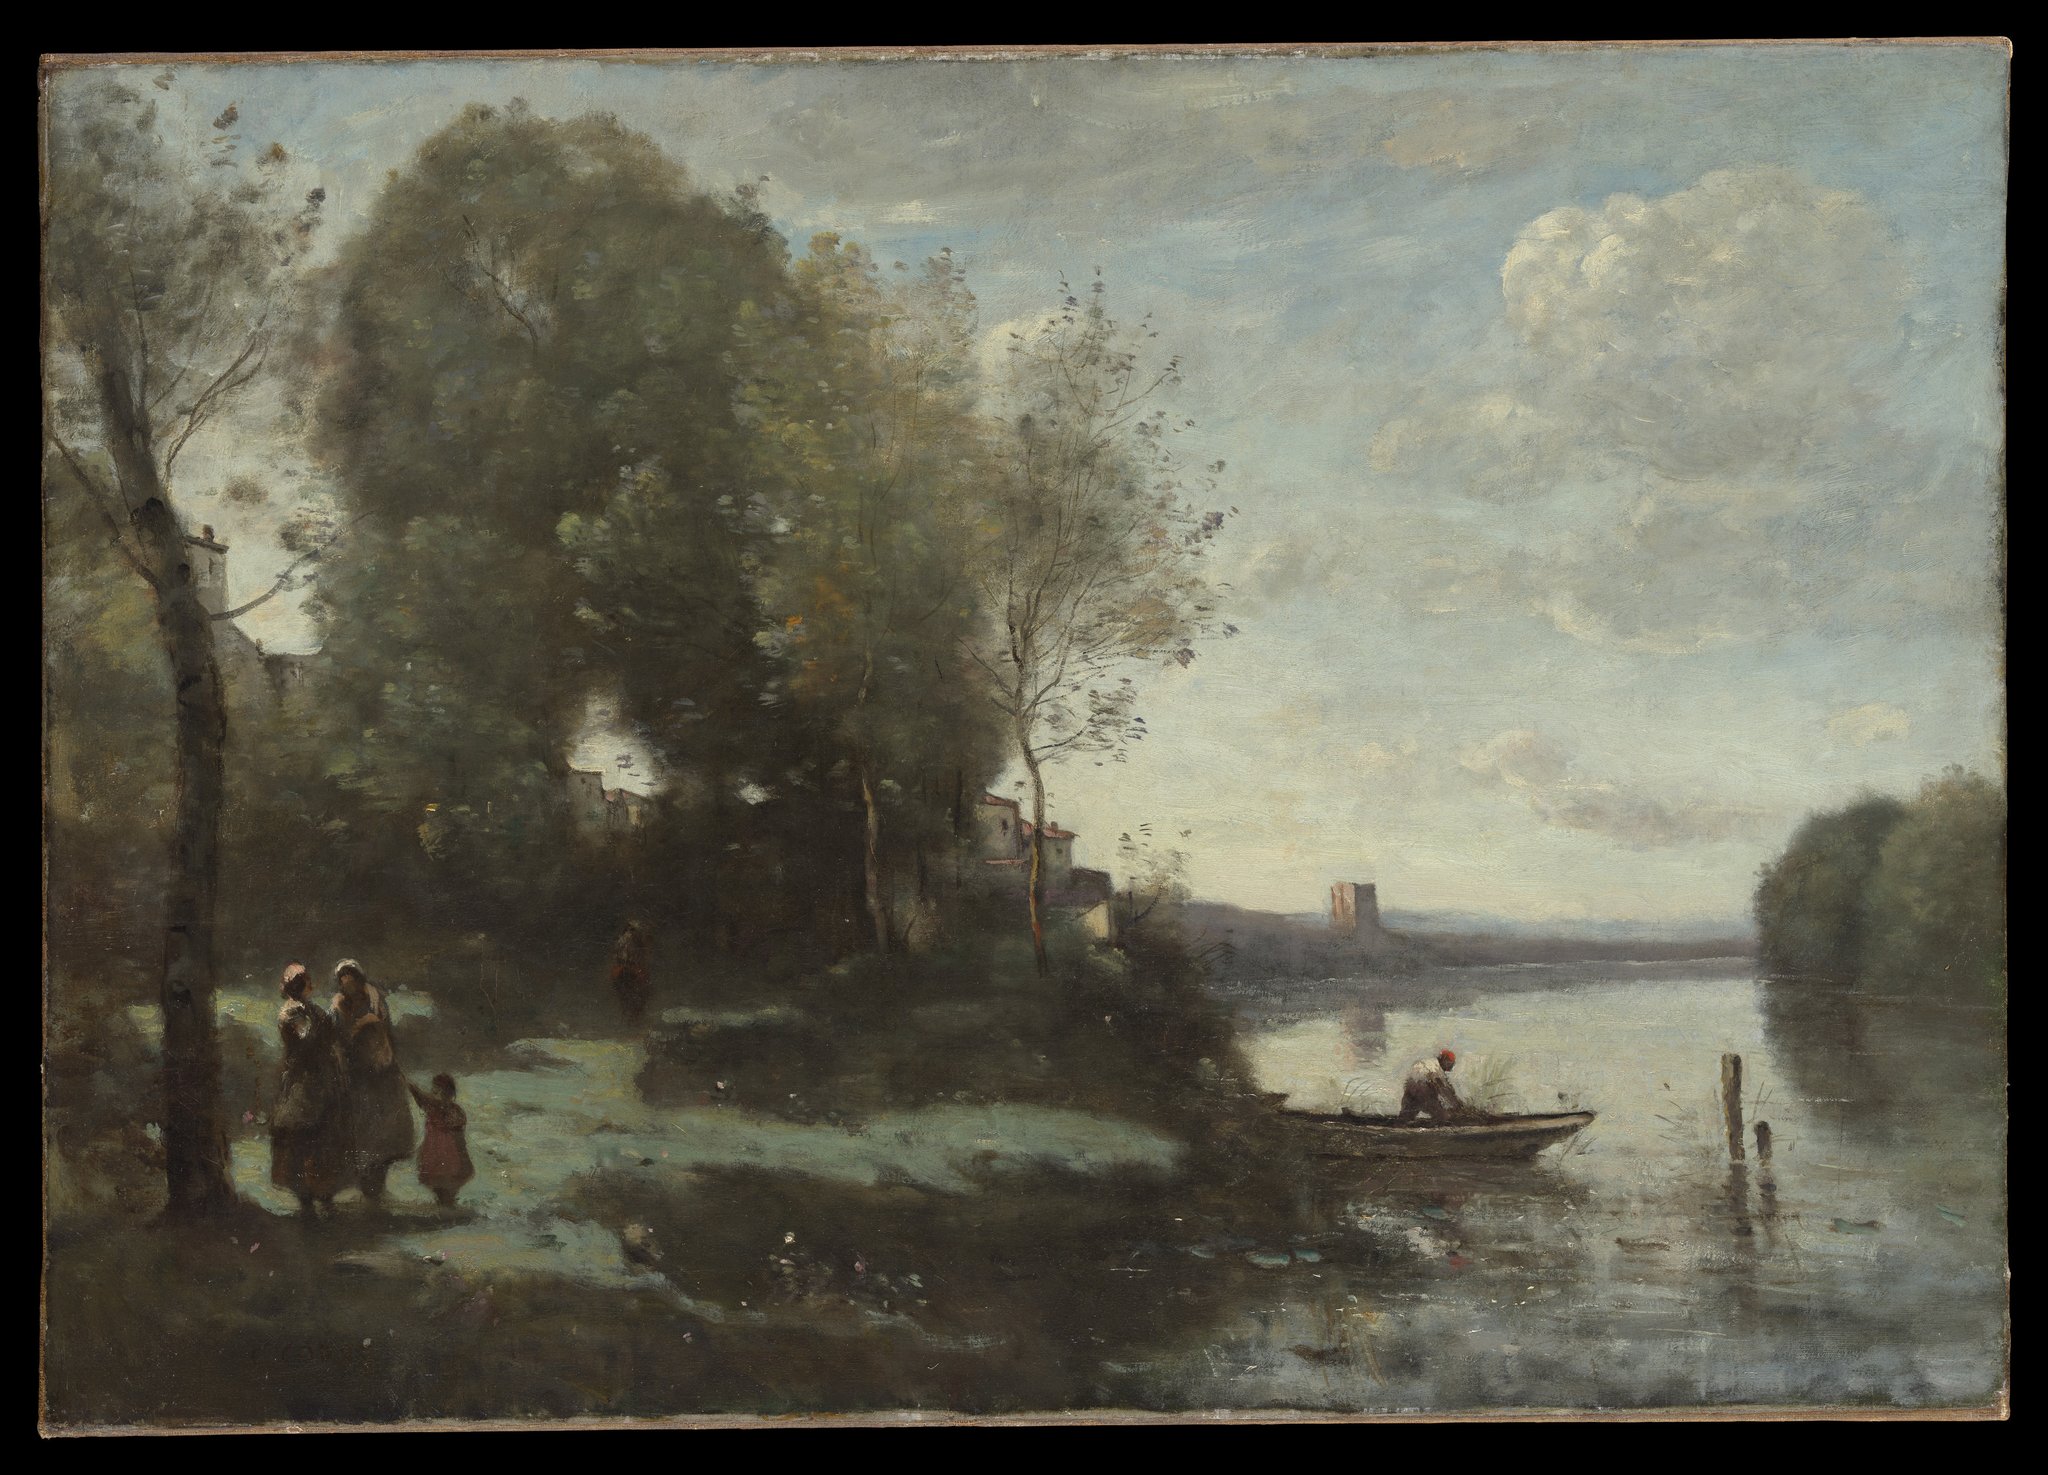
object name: painting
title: River with a Distant Tower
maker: jean-baptiste-camille corot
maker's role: artist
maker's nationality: french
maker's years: 1796-1875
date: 1865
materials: canvas, oil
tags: human figures,rivers,boats